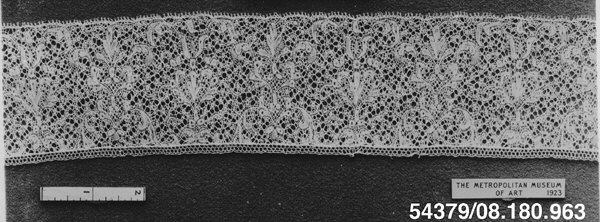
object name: strip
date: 1701-1733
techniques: lace